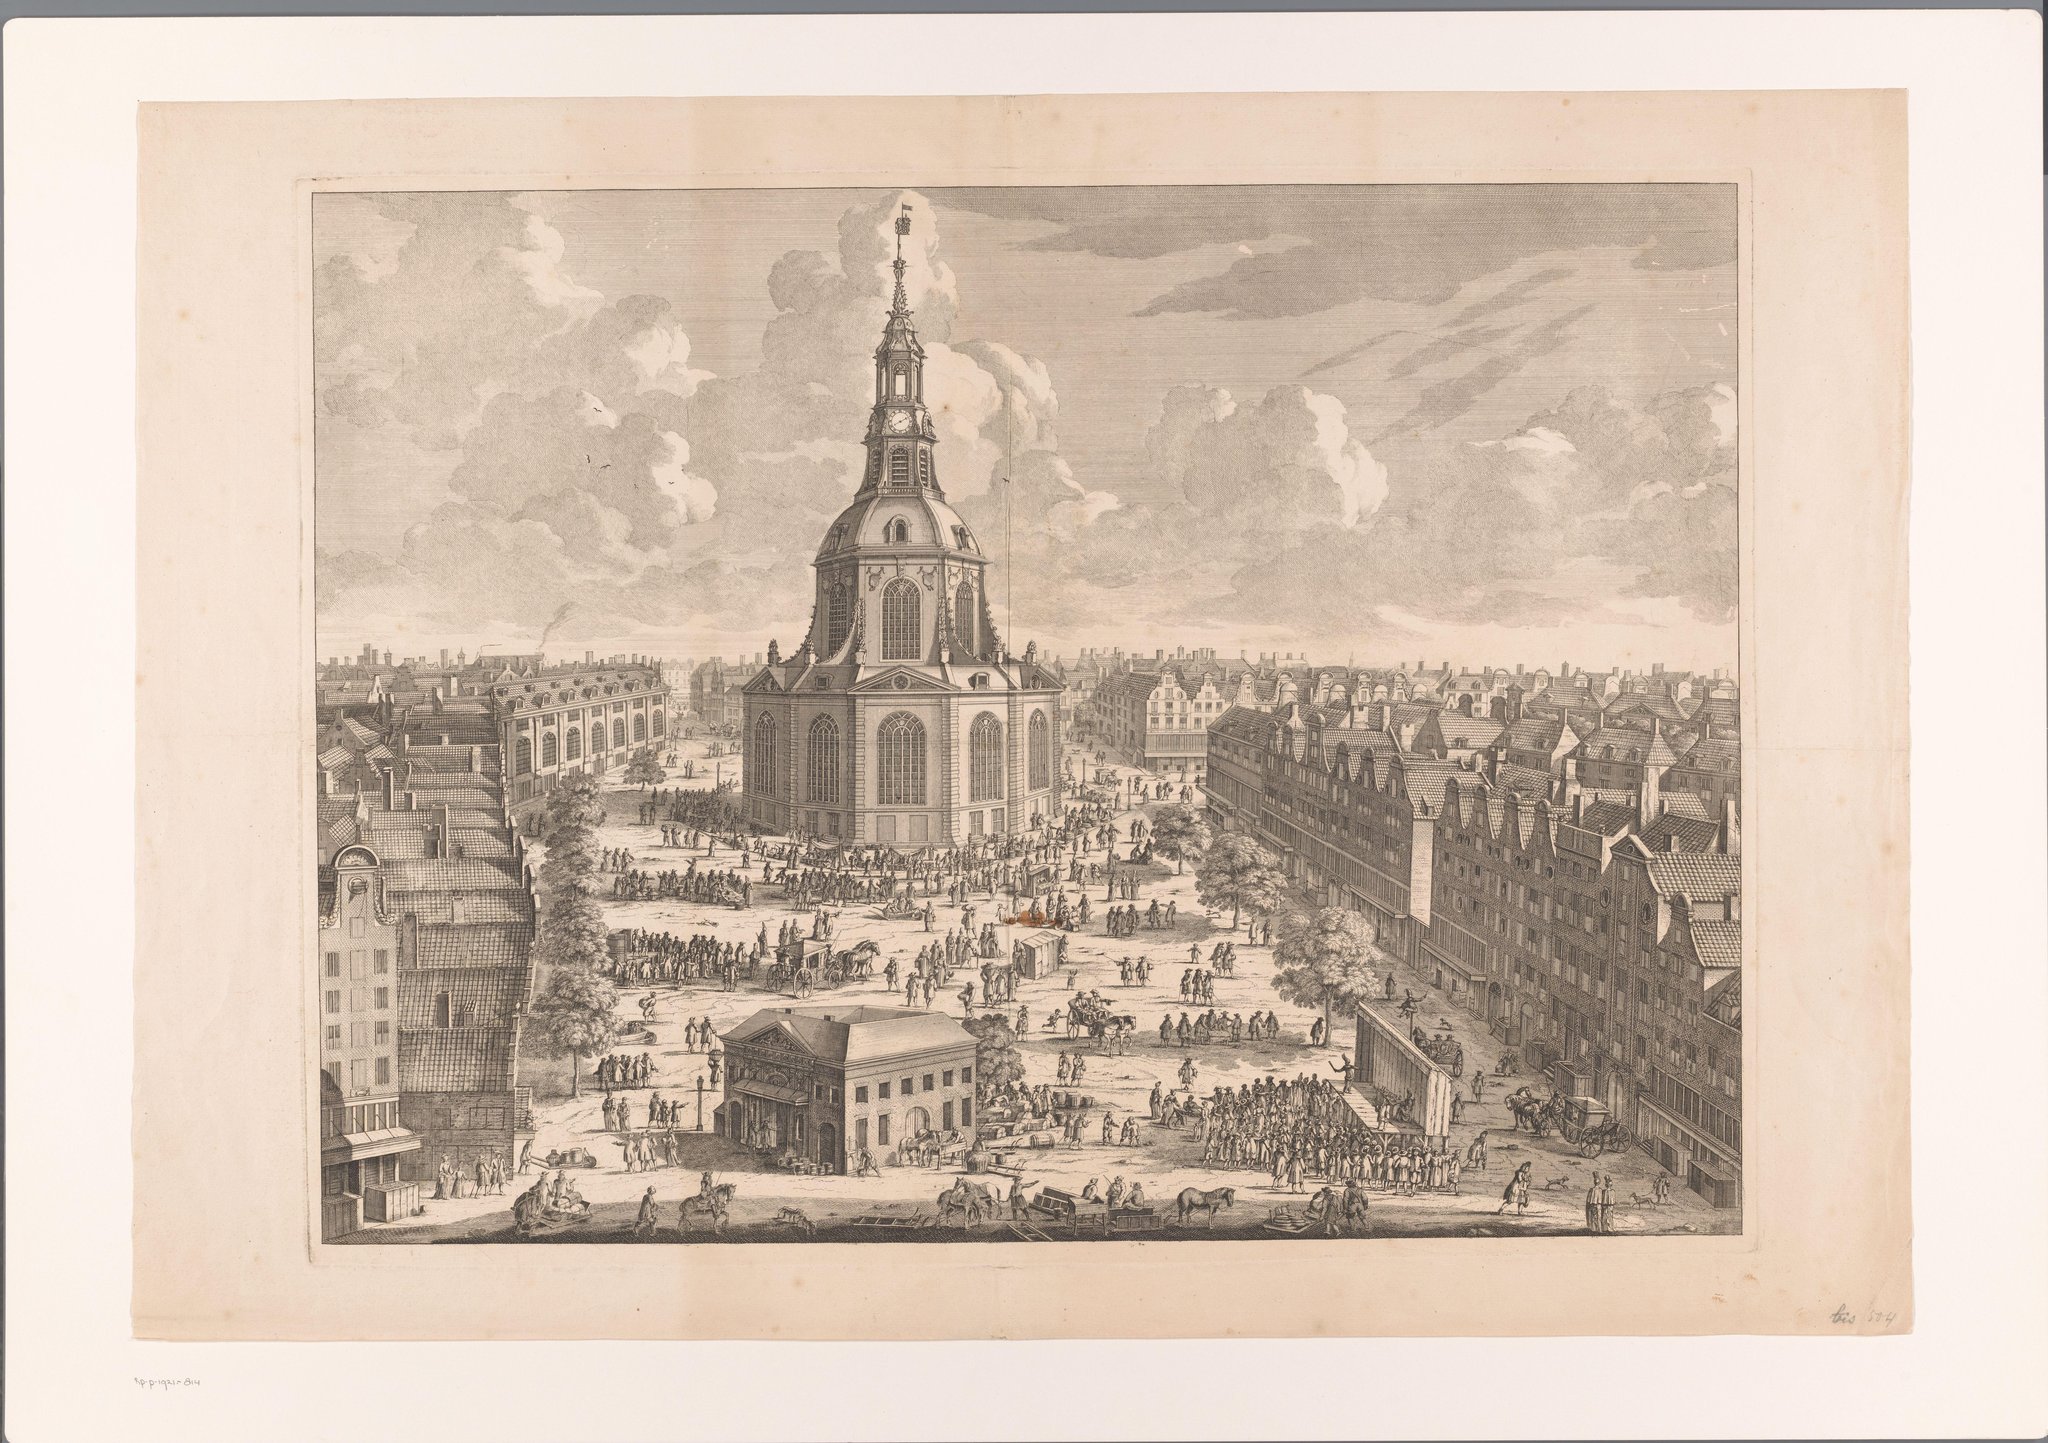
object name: print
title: Gezicht op de Botermarkt te Amsterdam met een nooit gebouwde koepelkerk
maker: daniël stopendaal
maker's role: print maker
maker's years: 1672-1726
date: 1729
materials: paper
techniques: engraving, etching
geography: amsterdam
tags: church (exterior), village square, place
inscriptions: collector's mark: Lugt 2233, inscription: ‘bis 504’